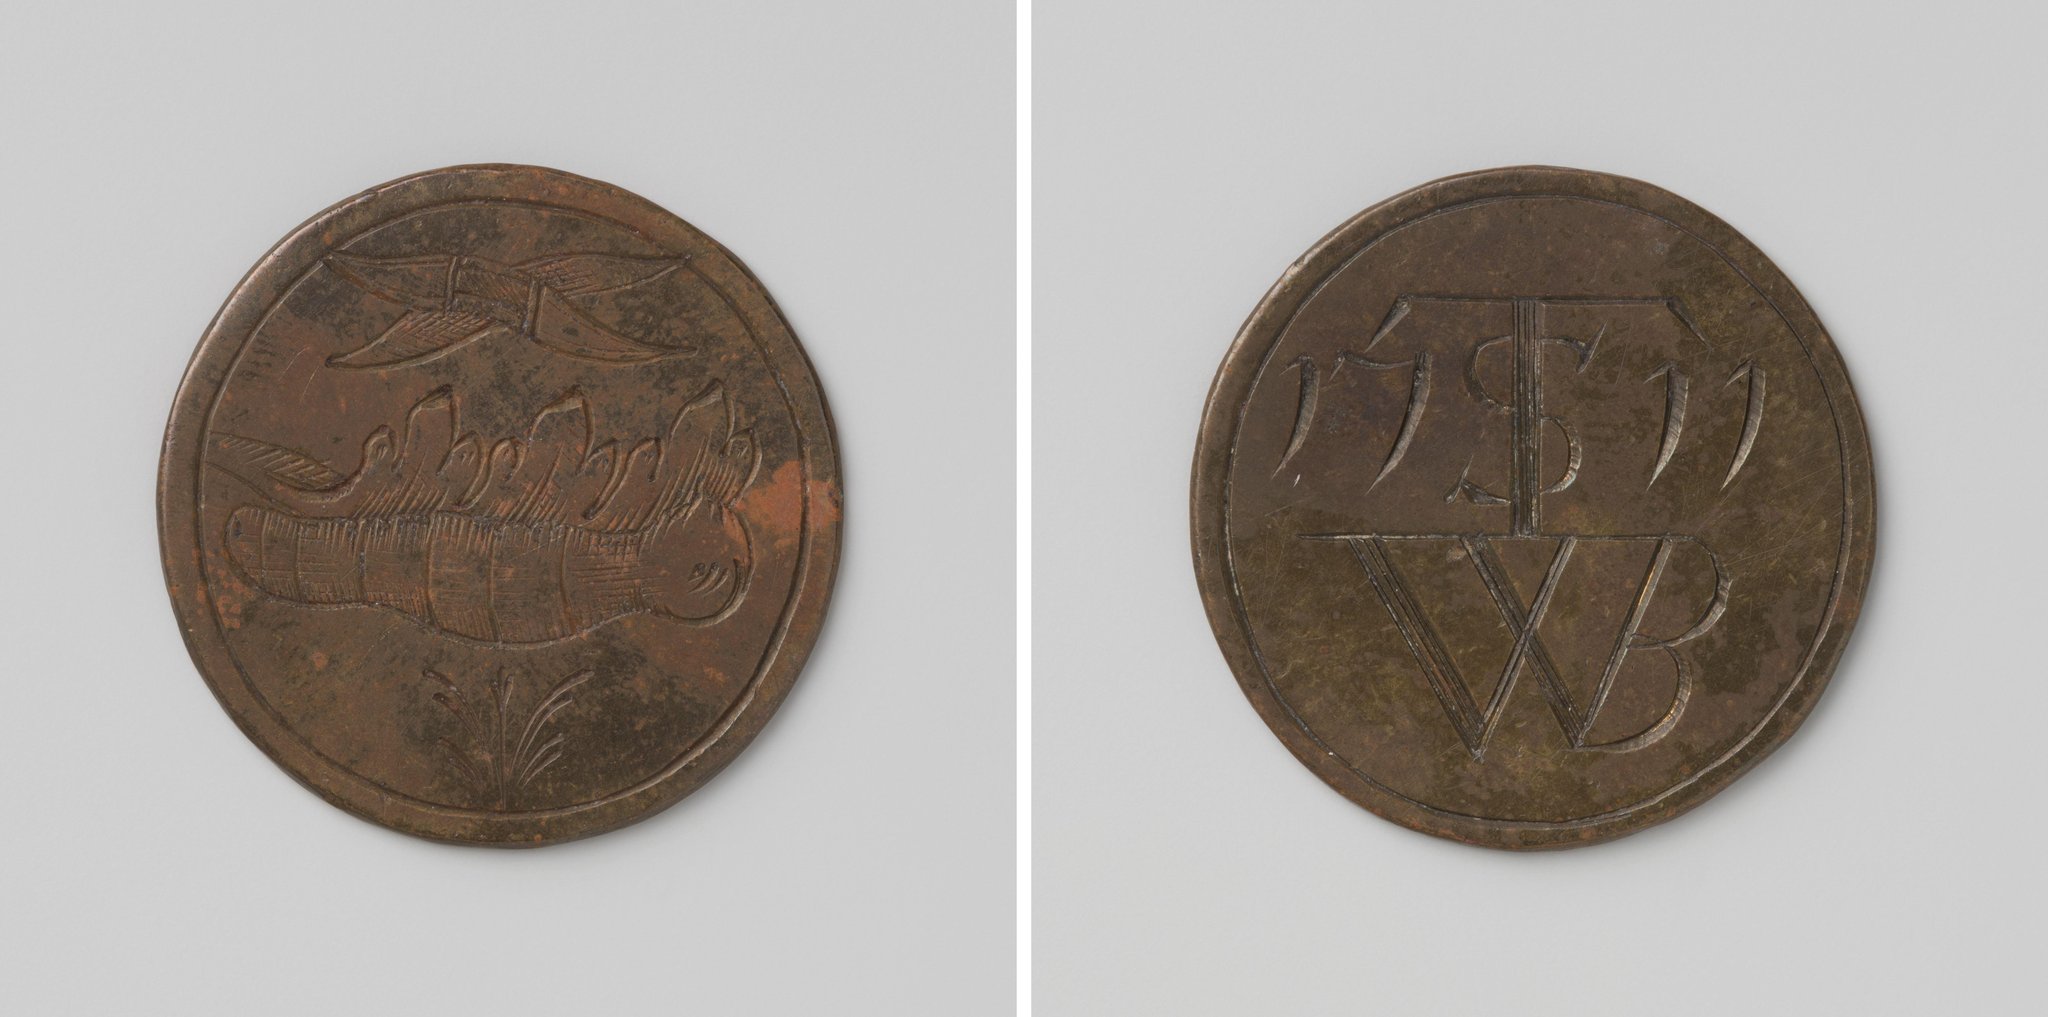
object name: medal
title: Gildebus van het stofjeswerkersgilde van Utrecht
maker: Anonymous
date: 1711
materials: brass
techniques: engraving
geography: utrecht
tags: utrecht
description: Messing penning. Voorzijde: twee gekruiste weversspoelen boven zijderups. Keerzijde: monogram van letters S, T, W en B tussen jaartal.